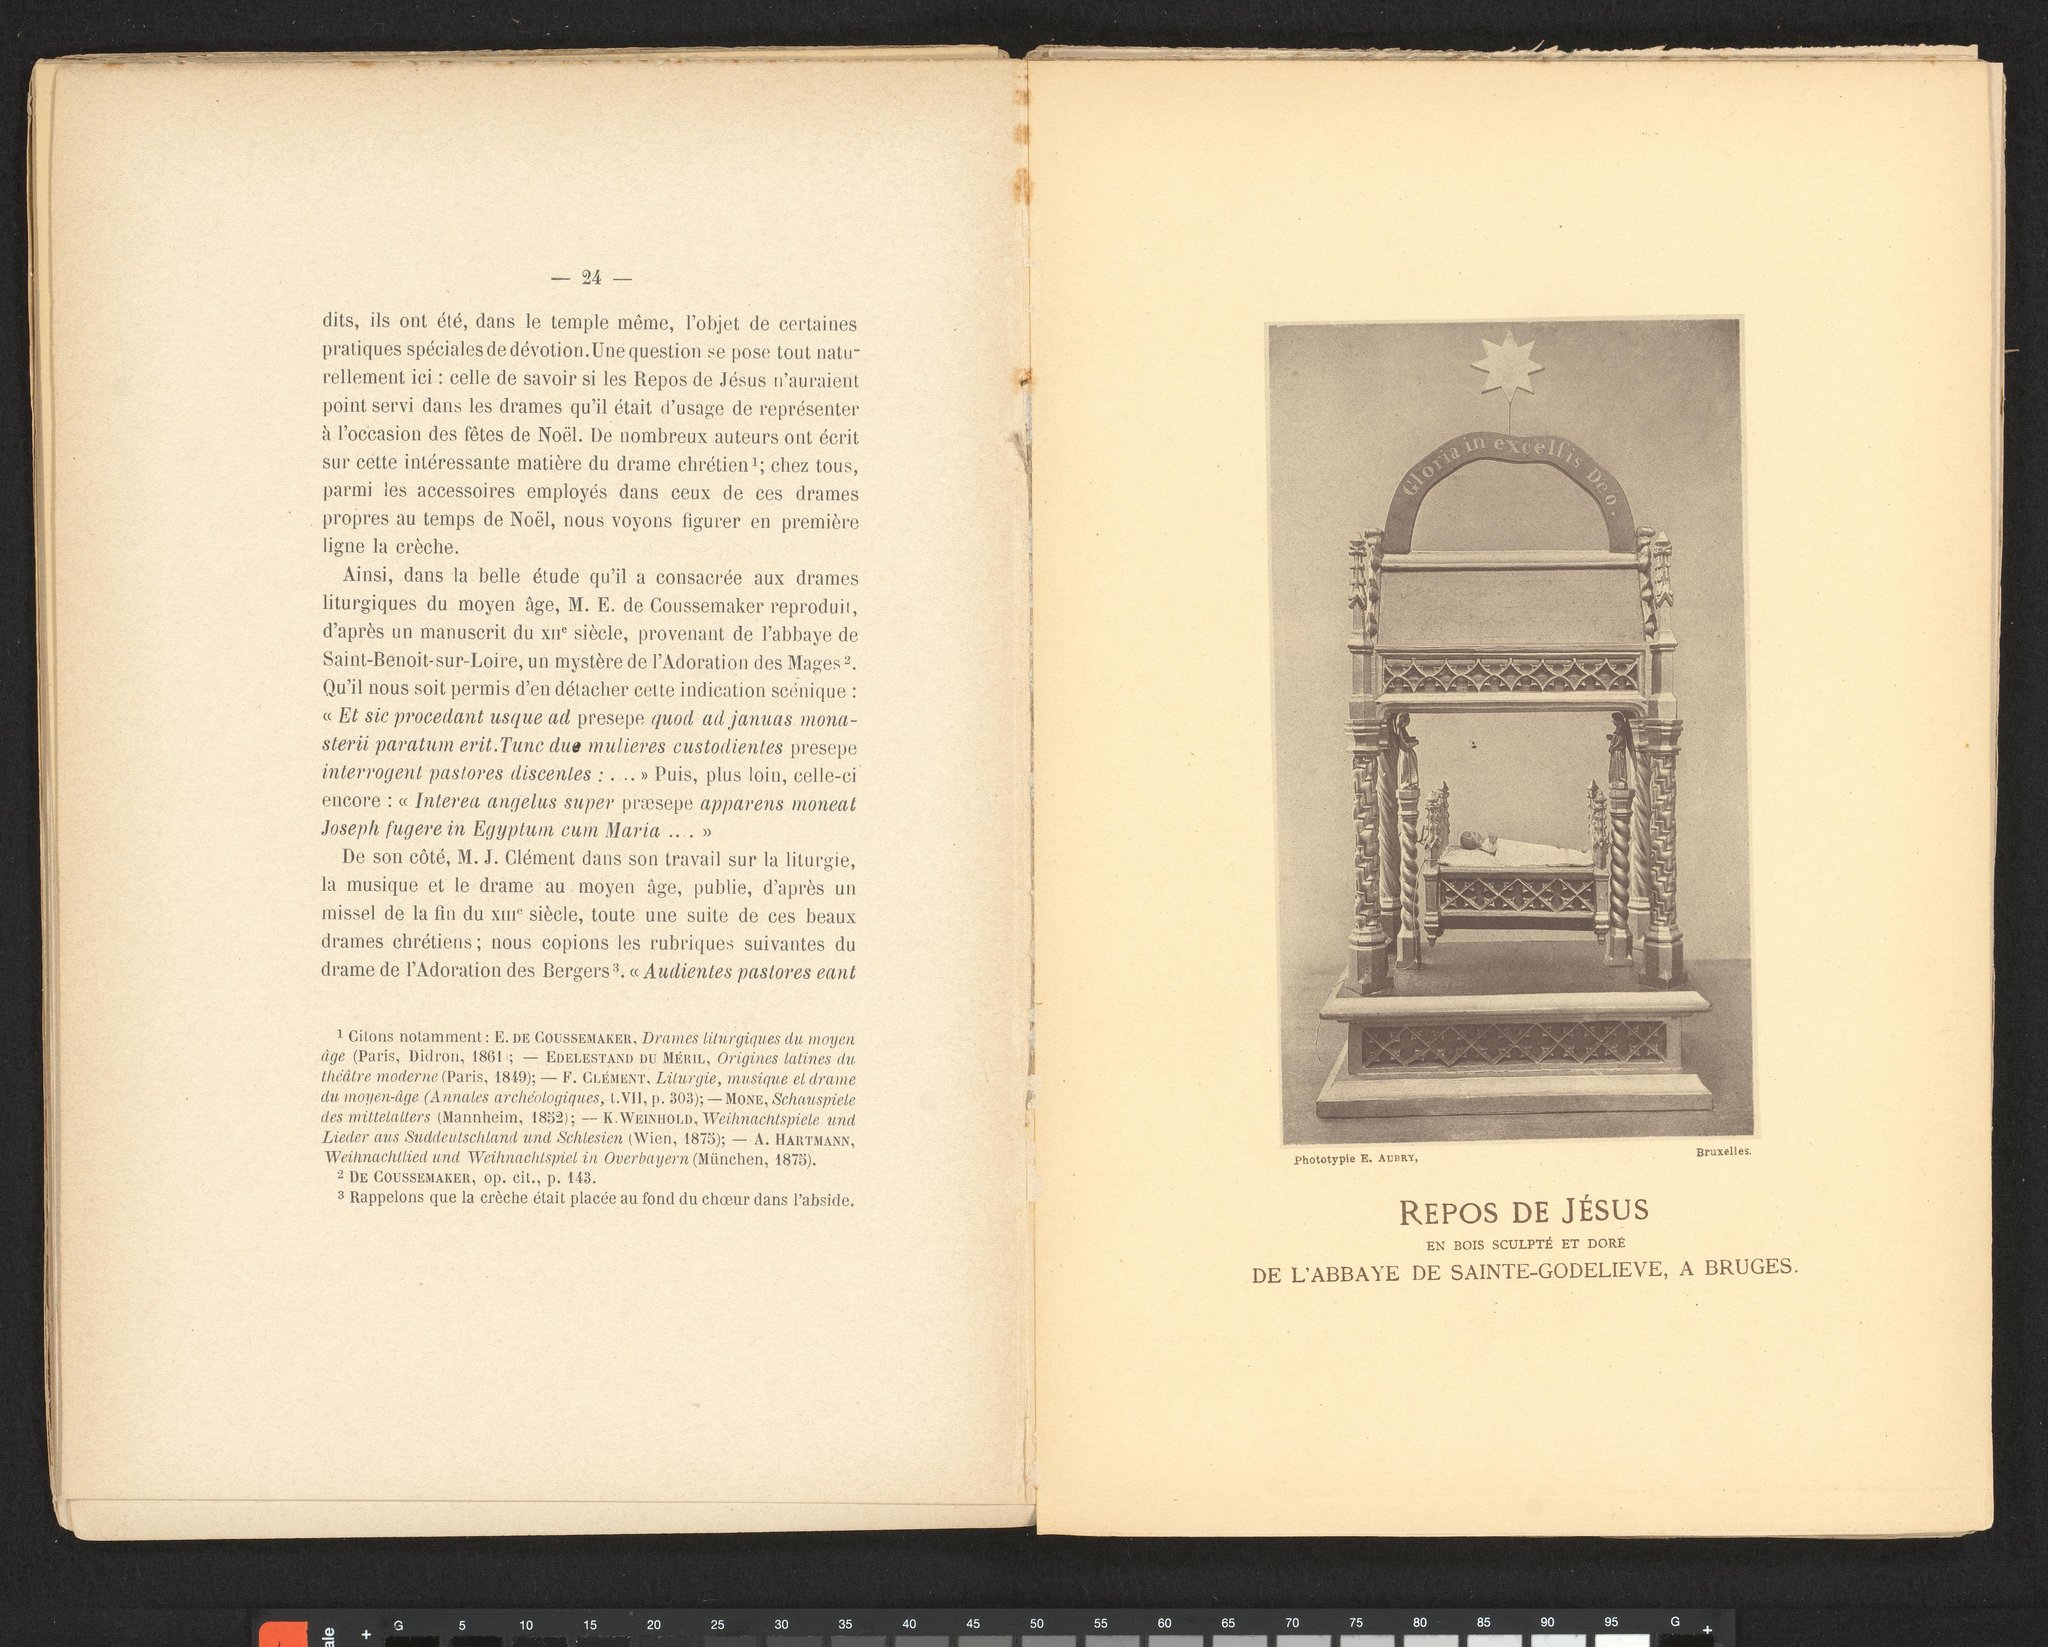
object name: page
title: Repos de Jésus en bois sculpté et doré de l'Abbaye de Sainte-Godelieve, a Bruges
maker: emile aubry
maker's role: print maker, printer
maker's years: 1829-1900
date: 1885-1890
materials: paper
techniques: photograph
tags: relics (and reliquaries)